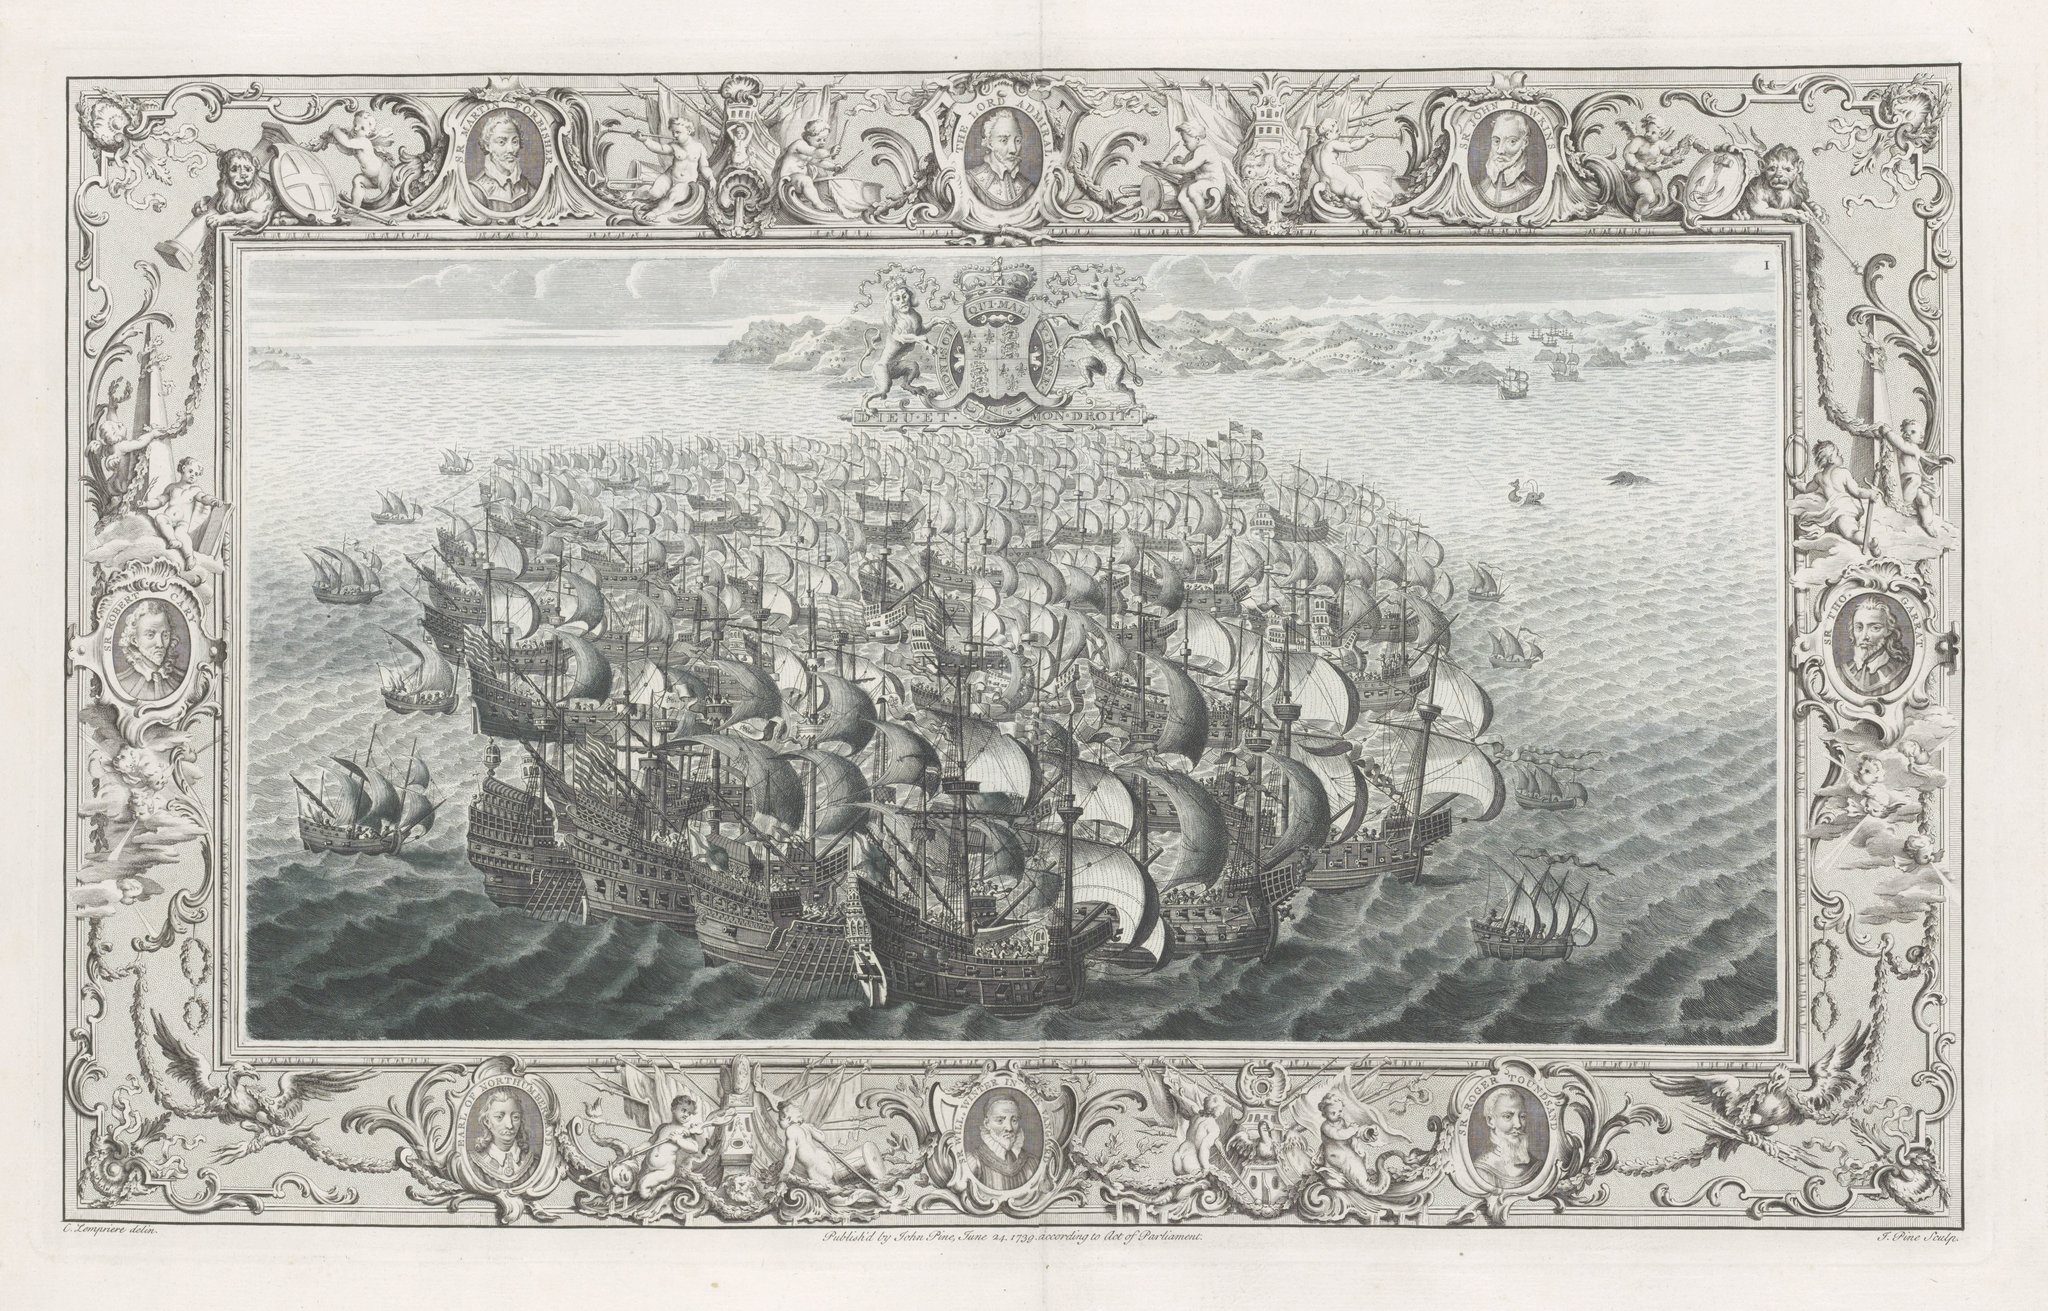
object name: print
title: Reproductie van een wandtapijt over de Spaanse Armada (16-20 juli)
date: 1739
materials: paper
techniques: engraving, etching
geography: london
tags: plymouth, coat of arms (as symbol of the state, etc.), obelisk, needle, wind as a human face, blowing with rounded cheeks, battle (+ naval force), parts of ship's exterior: bow, tapestry, cupids: 'amores', 'amoretti', 'putti', armorial bearing, heraldry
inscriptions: date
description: Spaanse vloot in Het Kanaal onder de kust van Cornwall en Devon met bovenaan het wapen van de Engelse koningin Elizabeth I. De voorstelling (rechtsboven genummerd I) is gevat in een ornamentrand met acht portretten van bevelhebbers van de Engelse vloot. Midden boven het portret van Charles Howard, Lord High Admiral en opperbevelhebber van de Engelse vloot tegen de Spaanse Armada. Boven en onder tussen de portretten scheepsboegen met speren en vaandels en geflankeerd door putti. Zij blazen op een bazuin of schelp, trommelen, schrijven etc. Links en rechts staan vier putti bij een triomf- of gedenkzuil. Twee putti versieren de zuil met guirlandes. Een derde putti schrijft de gebeurtenissen op een in boek; de vierde heeft een zwaard en ouroboros in de hand. De ouroboros is een slang die in zijn eigen staart bijt en is daarmee een symbool van de eeuwigheid. Verder twee adelaars met bliksemschichten, de vier winden en twee leeuwen met zuil of drietand en een wapenschild. De rechter toont het Anker van Hoop, het wapen van de Engelse Admiraliteit. De prent maakt deel uit van een album. De voorstelling maakt deel uit van een boek over de Spaanse Armada en de tapijten die daarover in opdracht van Charles Howard werden gemaakt.